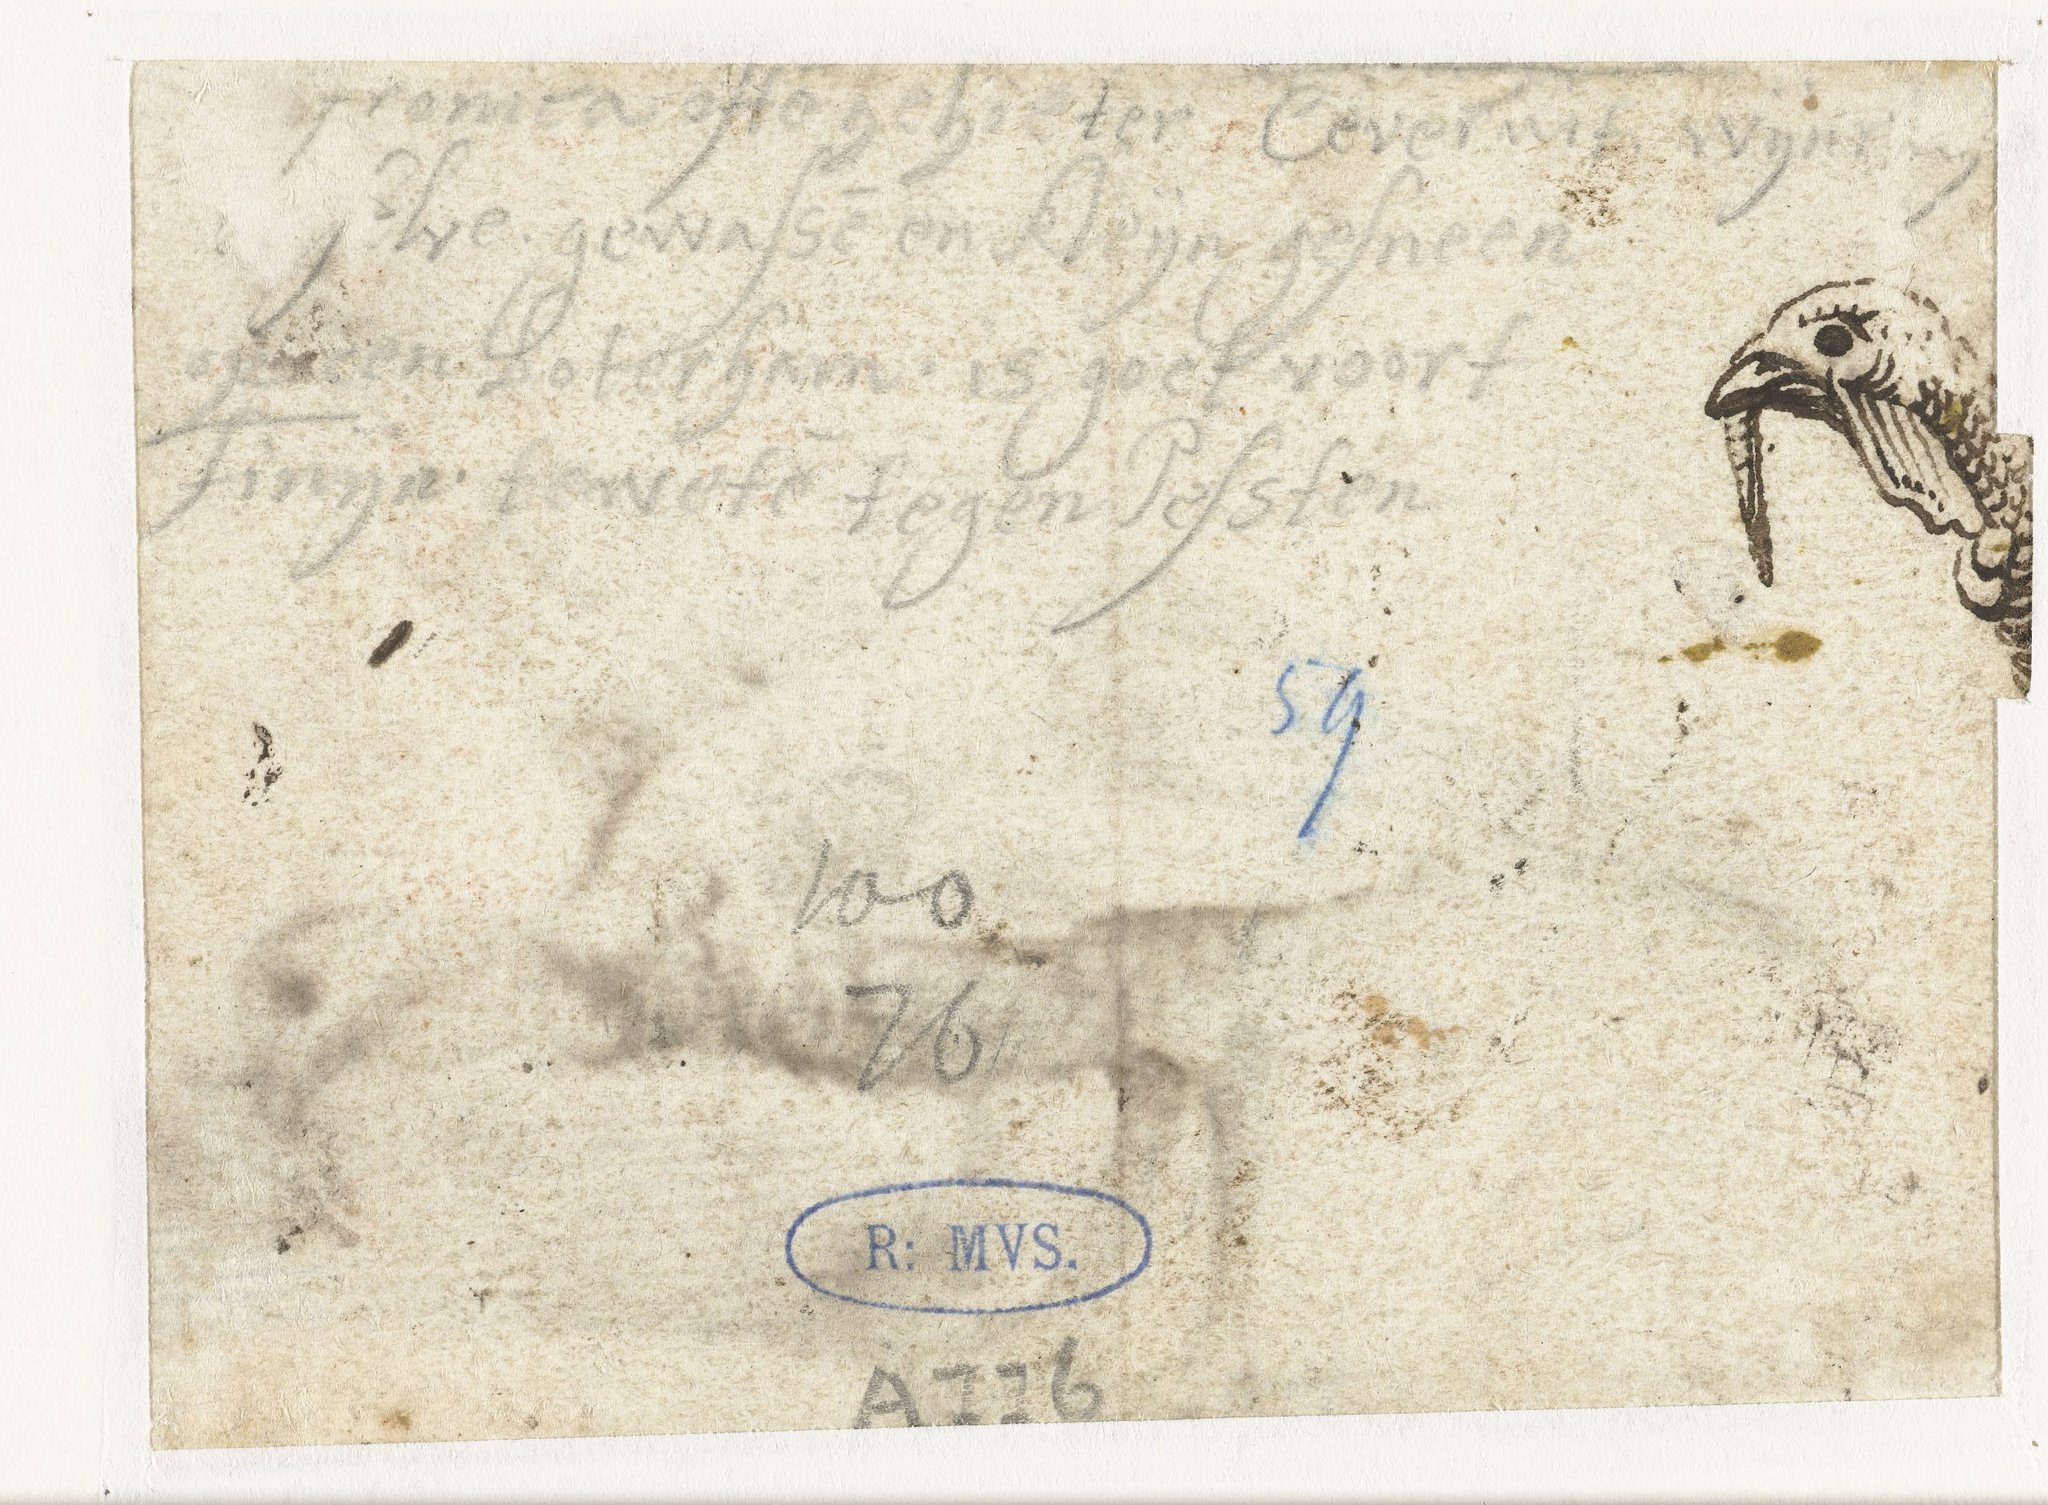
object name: drawing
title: Kop van een kalkoen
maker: gerard ter borch (i)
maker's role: draughtsman, print maker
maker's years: 1584-1662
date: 1611-1612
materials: ink, paper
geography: italy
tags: walker and runner birds: turkey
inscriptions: annotation: ‘[...]fronita ofte hohieter Cove/ selve gewassen en kleyn gesneen/op een boterham is goet voort/Firyn te weten tegen pessten’